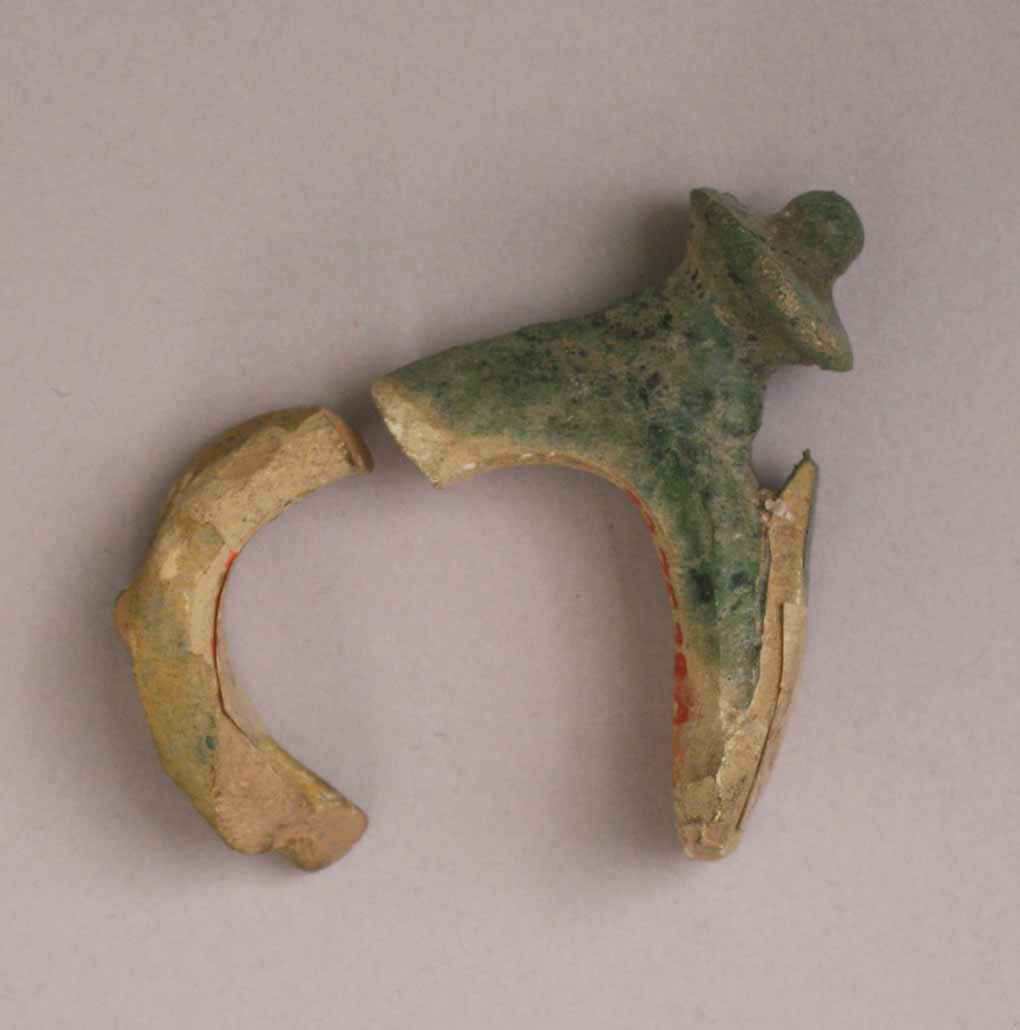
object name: handle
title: Fragments of a Green Glazed Handle with Knob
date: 801-900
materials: earthenware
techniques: glazing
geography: iraq